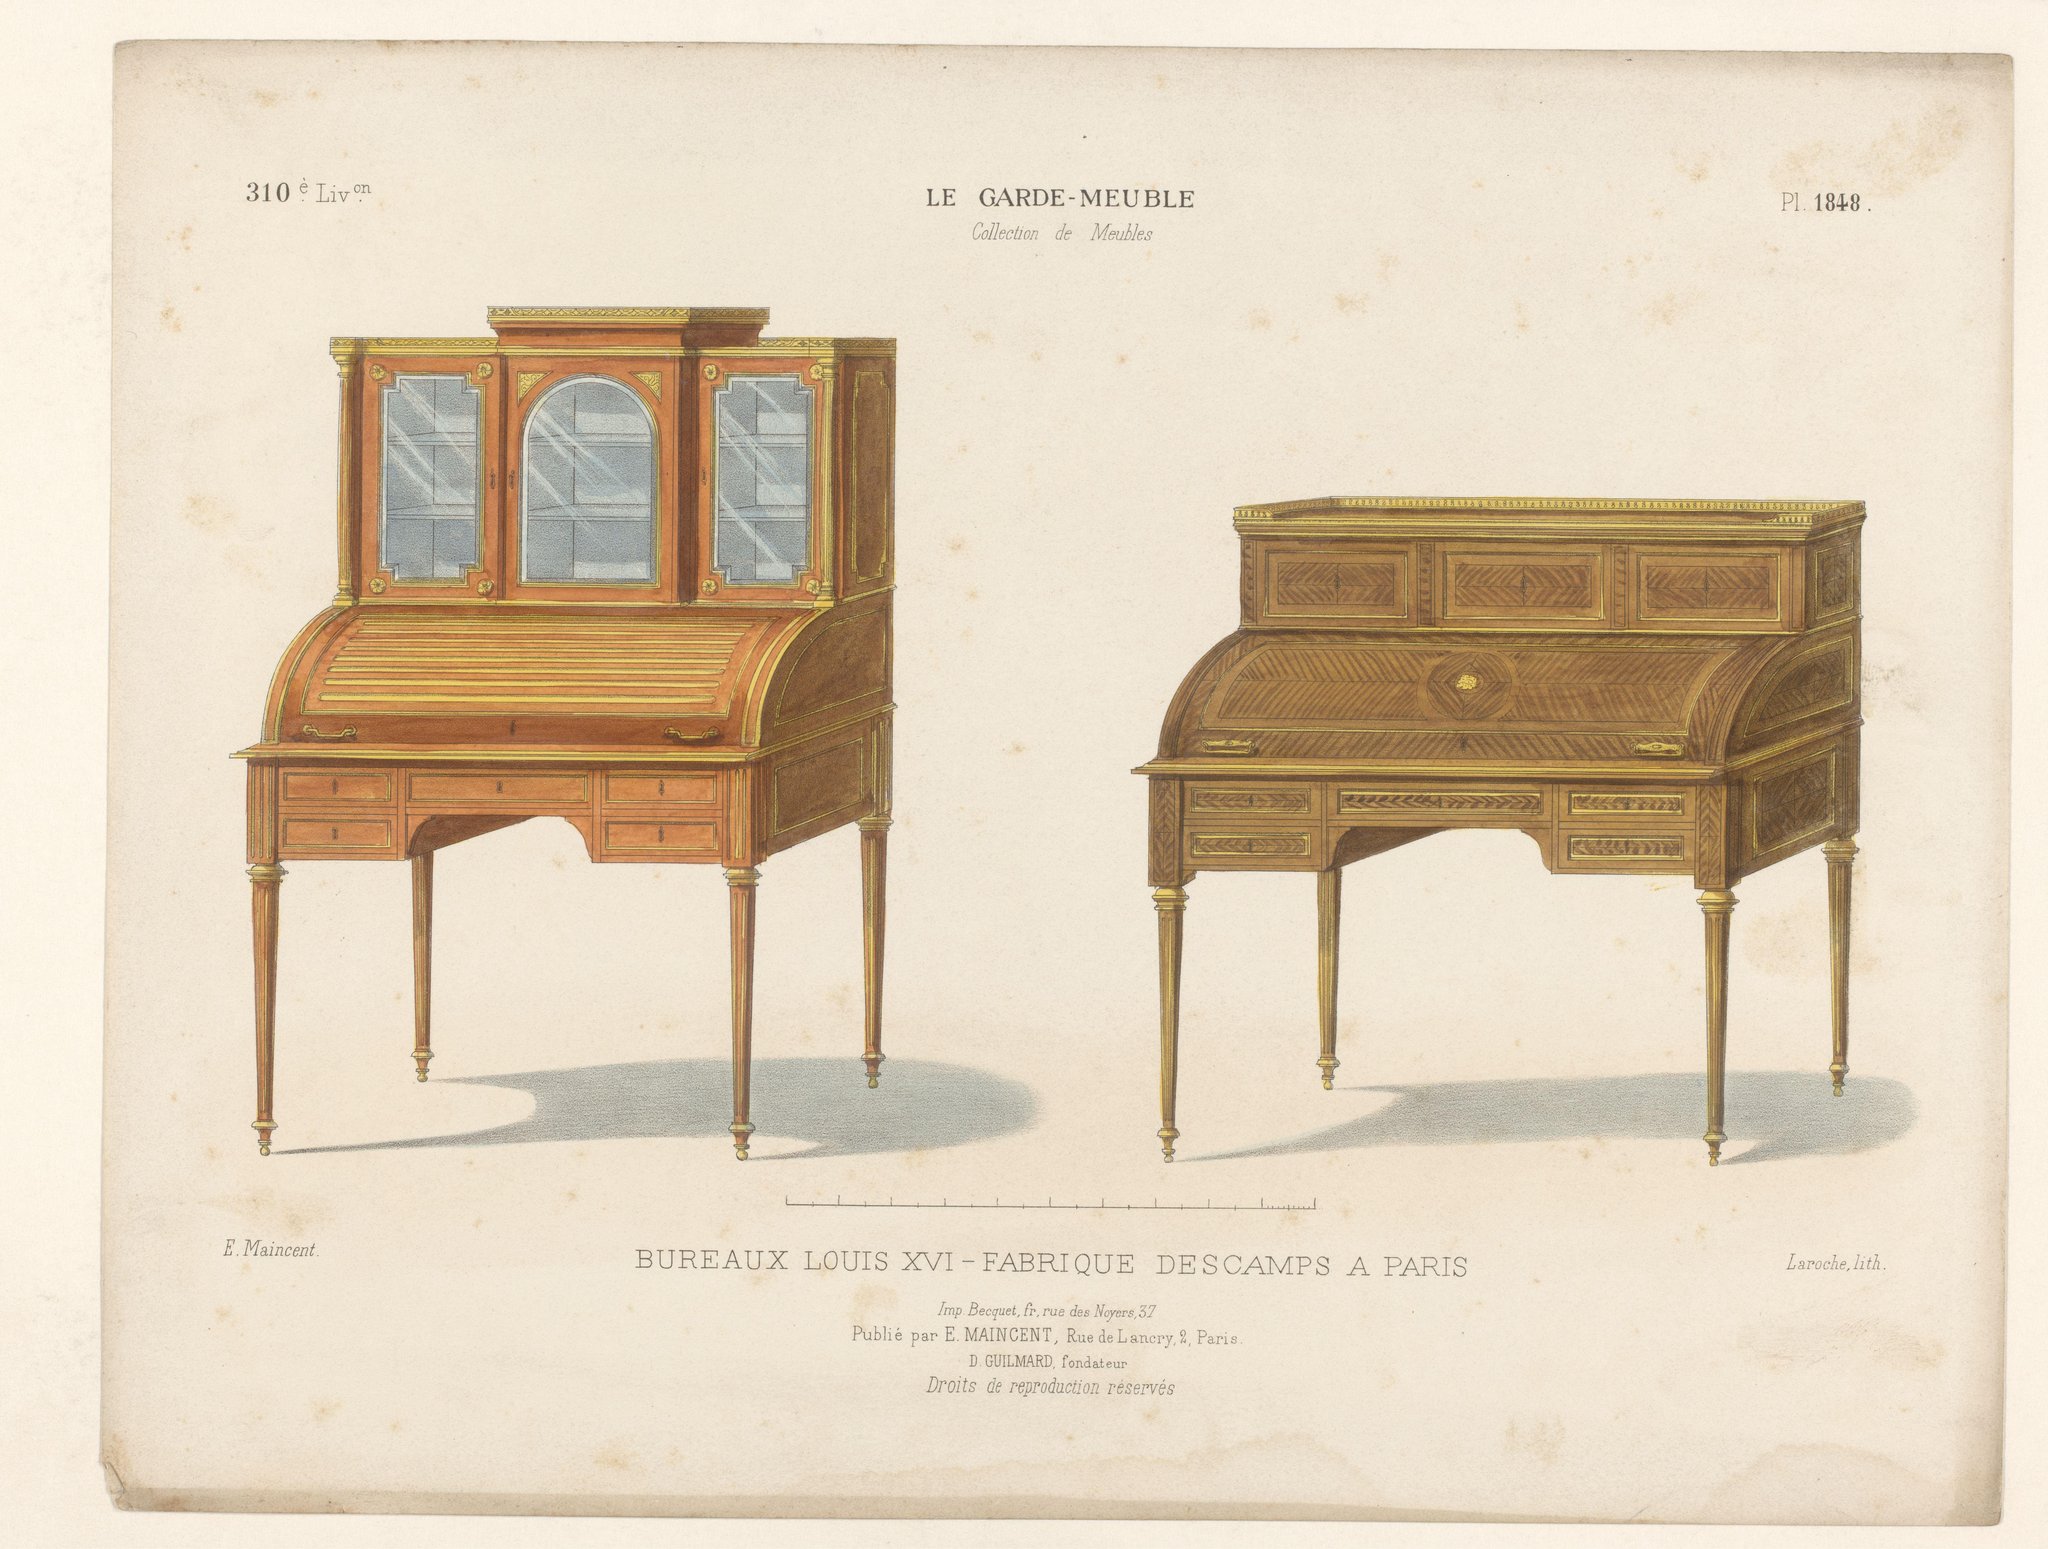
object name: print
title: Bureau Louis XVI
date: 1885-1895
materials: paper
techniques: hand coloring, lithograph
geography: paris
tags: writing-table, writing-desk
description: Ieder Livraison in de serie Le Garde-Meuble bevat negen platen: drie 'sièges' (zitmeubels), drie 'meubles' (diverse meubels zoals tafels en kasten) en drie 'tentures' (gordijnen en draperieën).